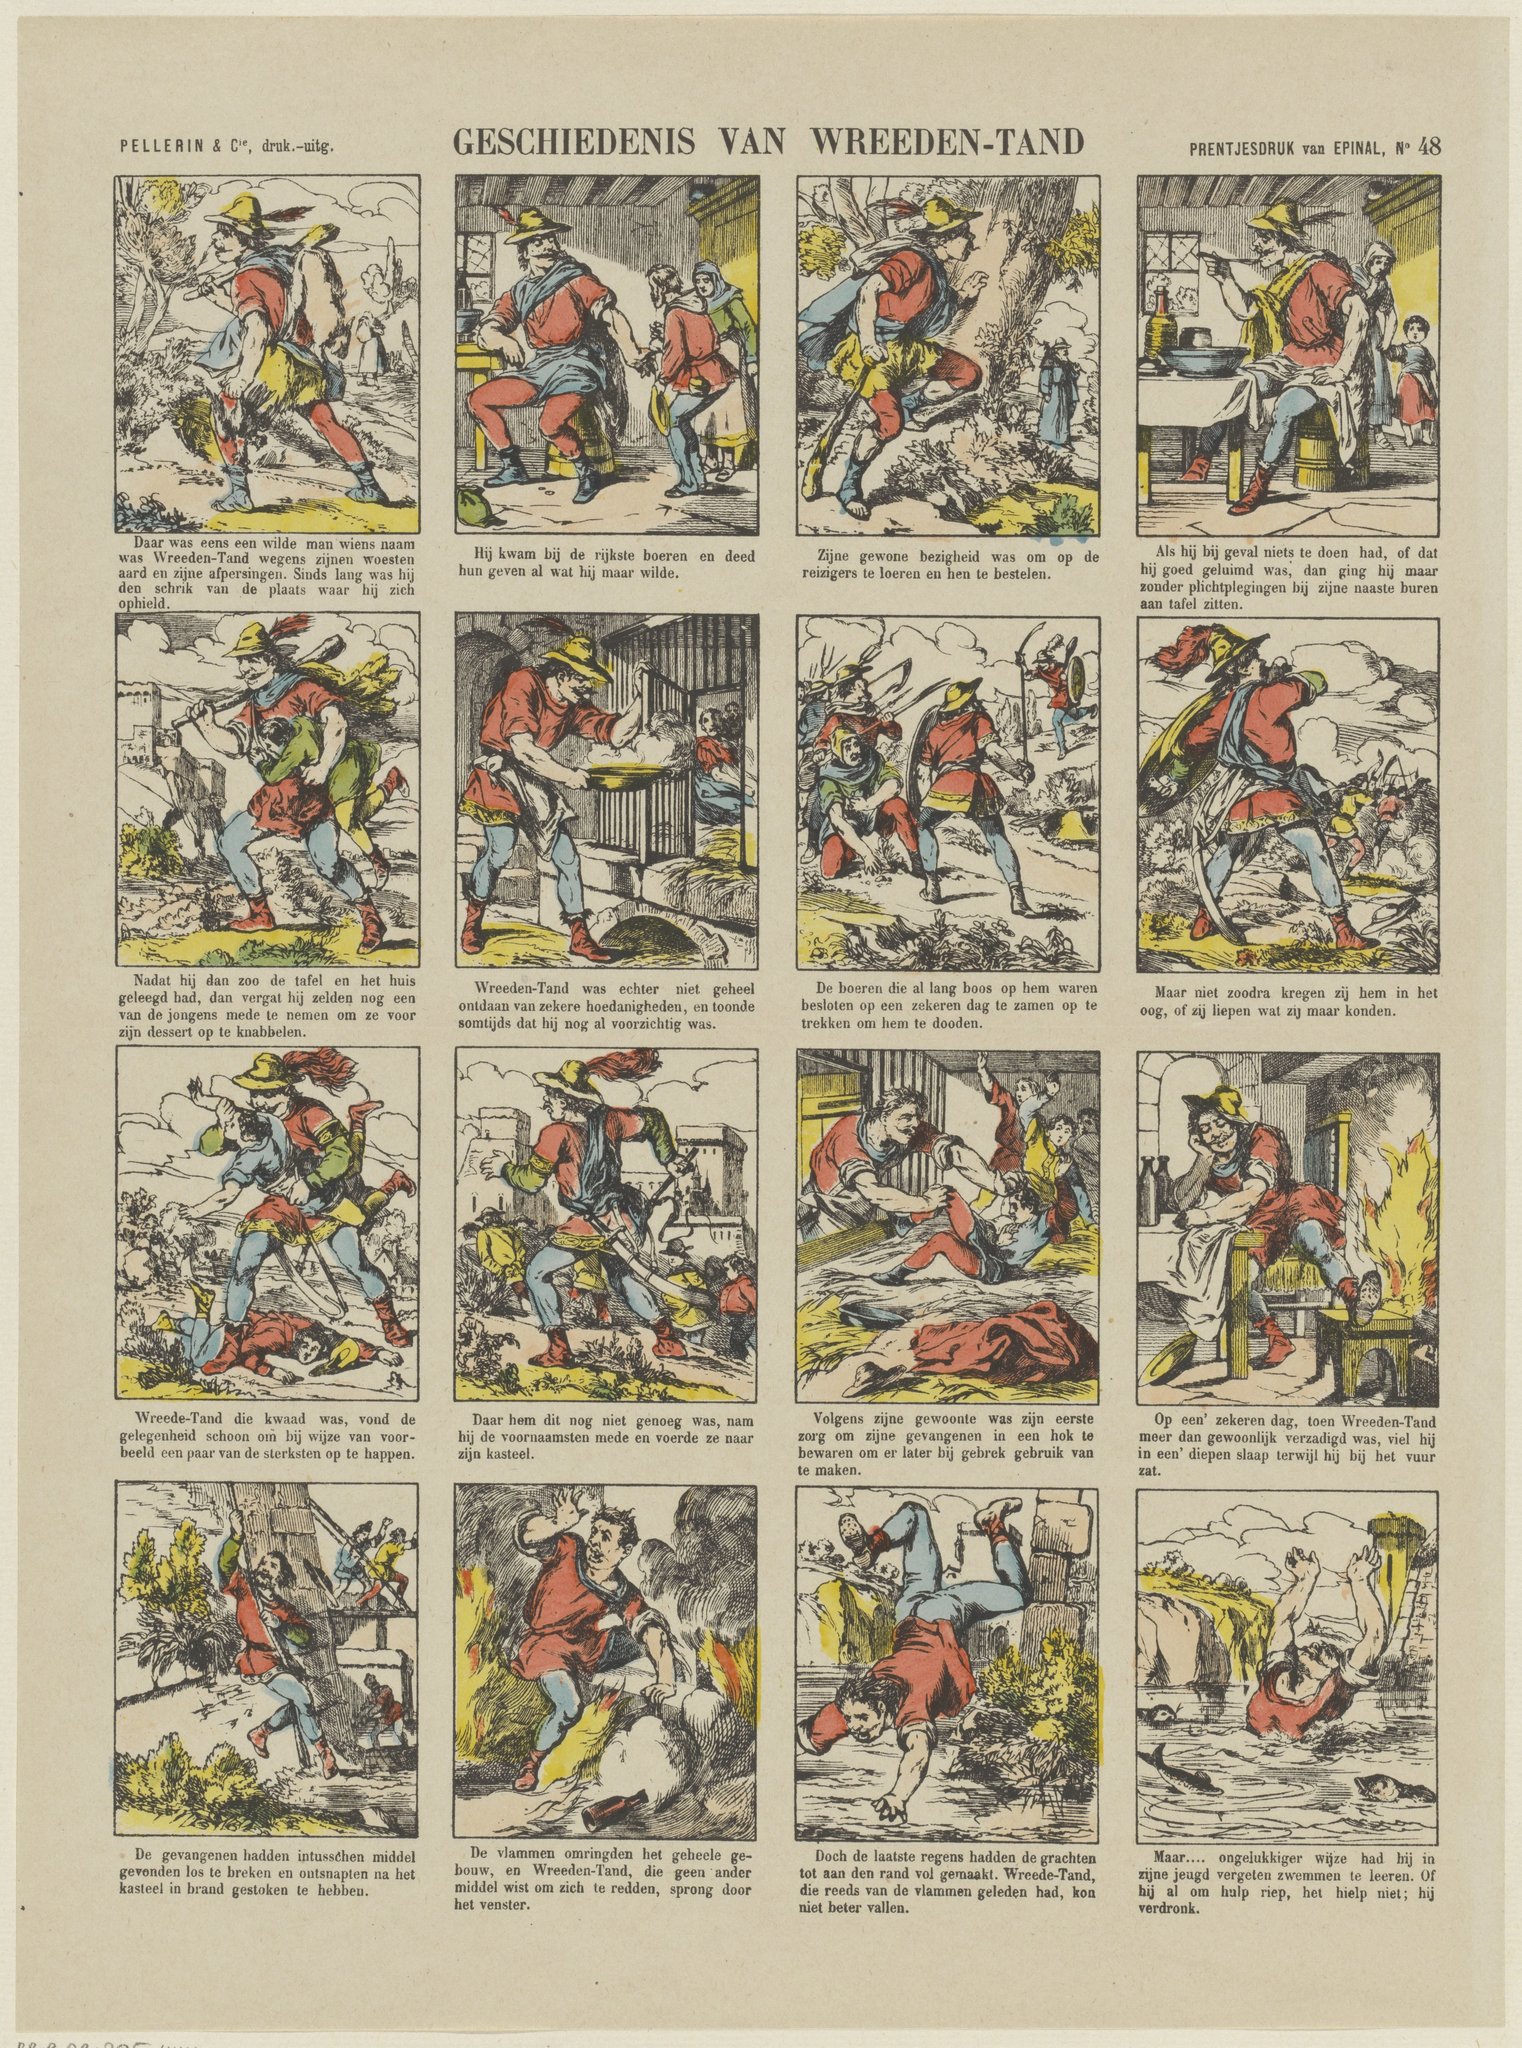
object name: popular print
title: Prentjesdruk van Épinal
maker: Anonymous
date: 1902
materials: paper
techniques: colour, letterpress printing, lithograph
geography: epinal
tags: thief, murderer, drowning (violent death ~ water)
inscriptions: collector's mark: Lugt 2760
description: Blad met 16 voorstellingen over het leven van de schurk Wreeden-tand, die steelt en kinderen eet. Onder elke afbeelding een onderschrift. Genummerd rechtsboven: No 48.